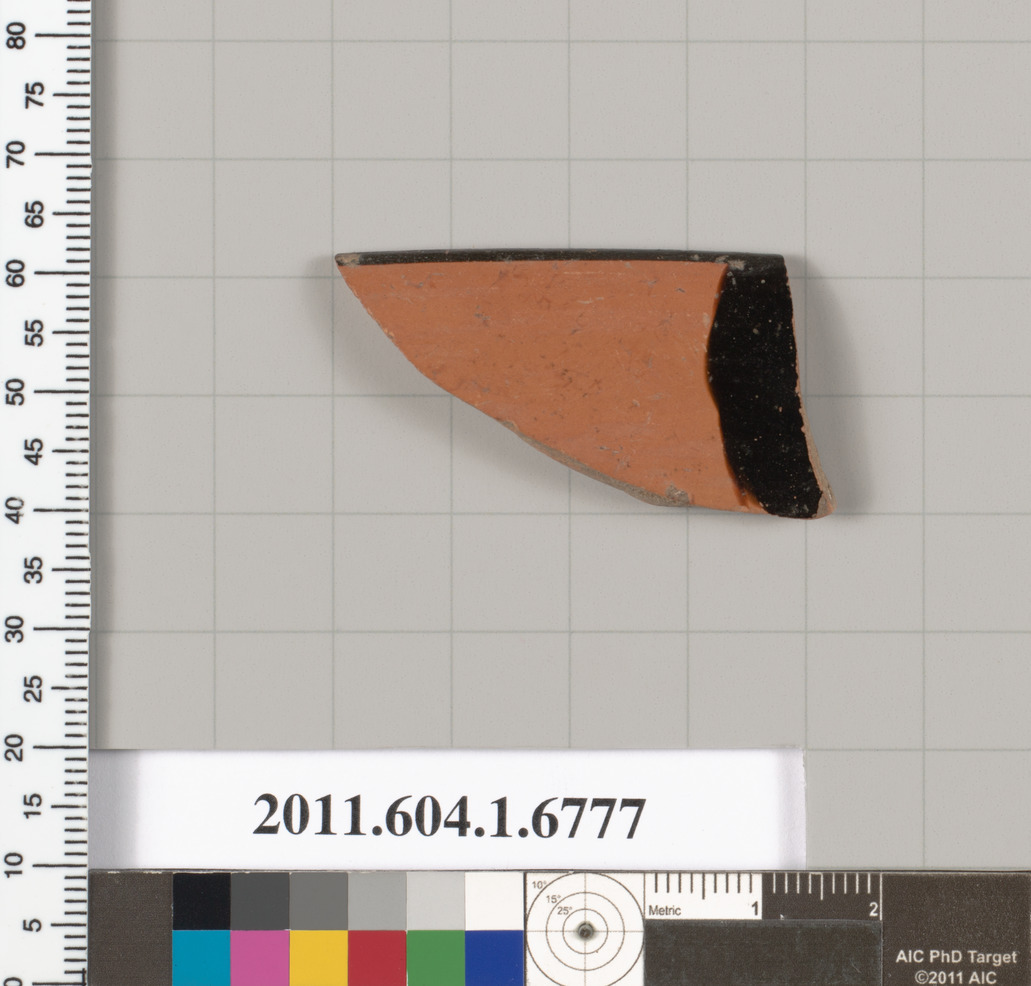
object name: kylix fragment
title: Terracotta fragment of a kylix (drinking cup)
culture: greek, attic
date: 490-470 BCE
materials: terracotta